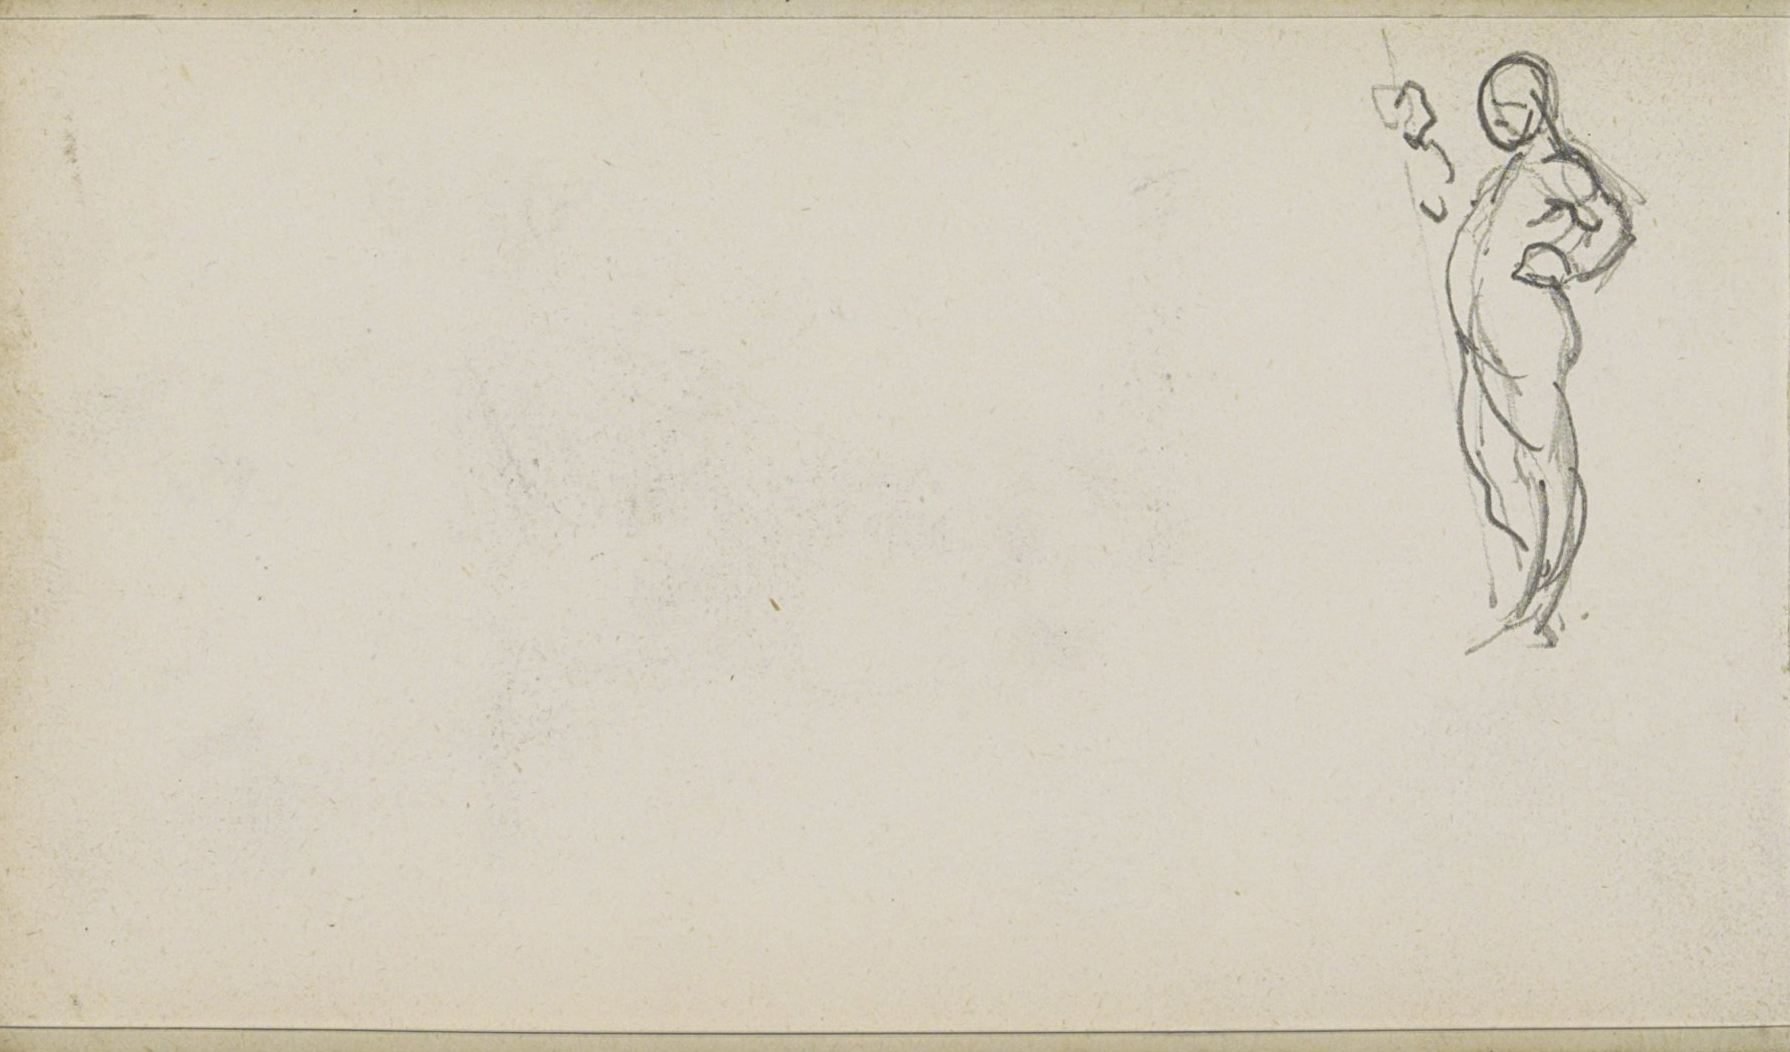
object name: sketchbook leaf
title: Staande figuur, de linkerarm op de zij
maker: george clausen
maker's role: draughtsman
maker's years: 1852-1912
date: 1875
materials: paper, pencil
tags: standing figure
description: Blad 15 verso uit een schetsboek met 46 bladen.